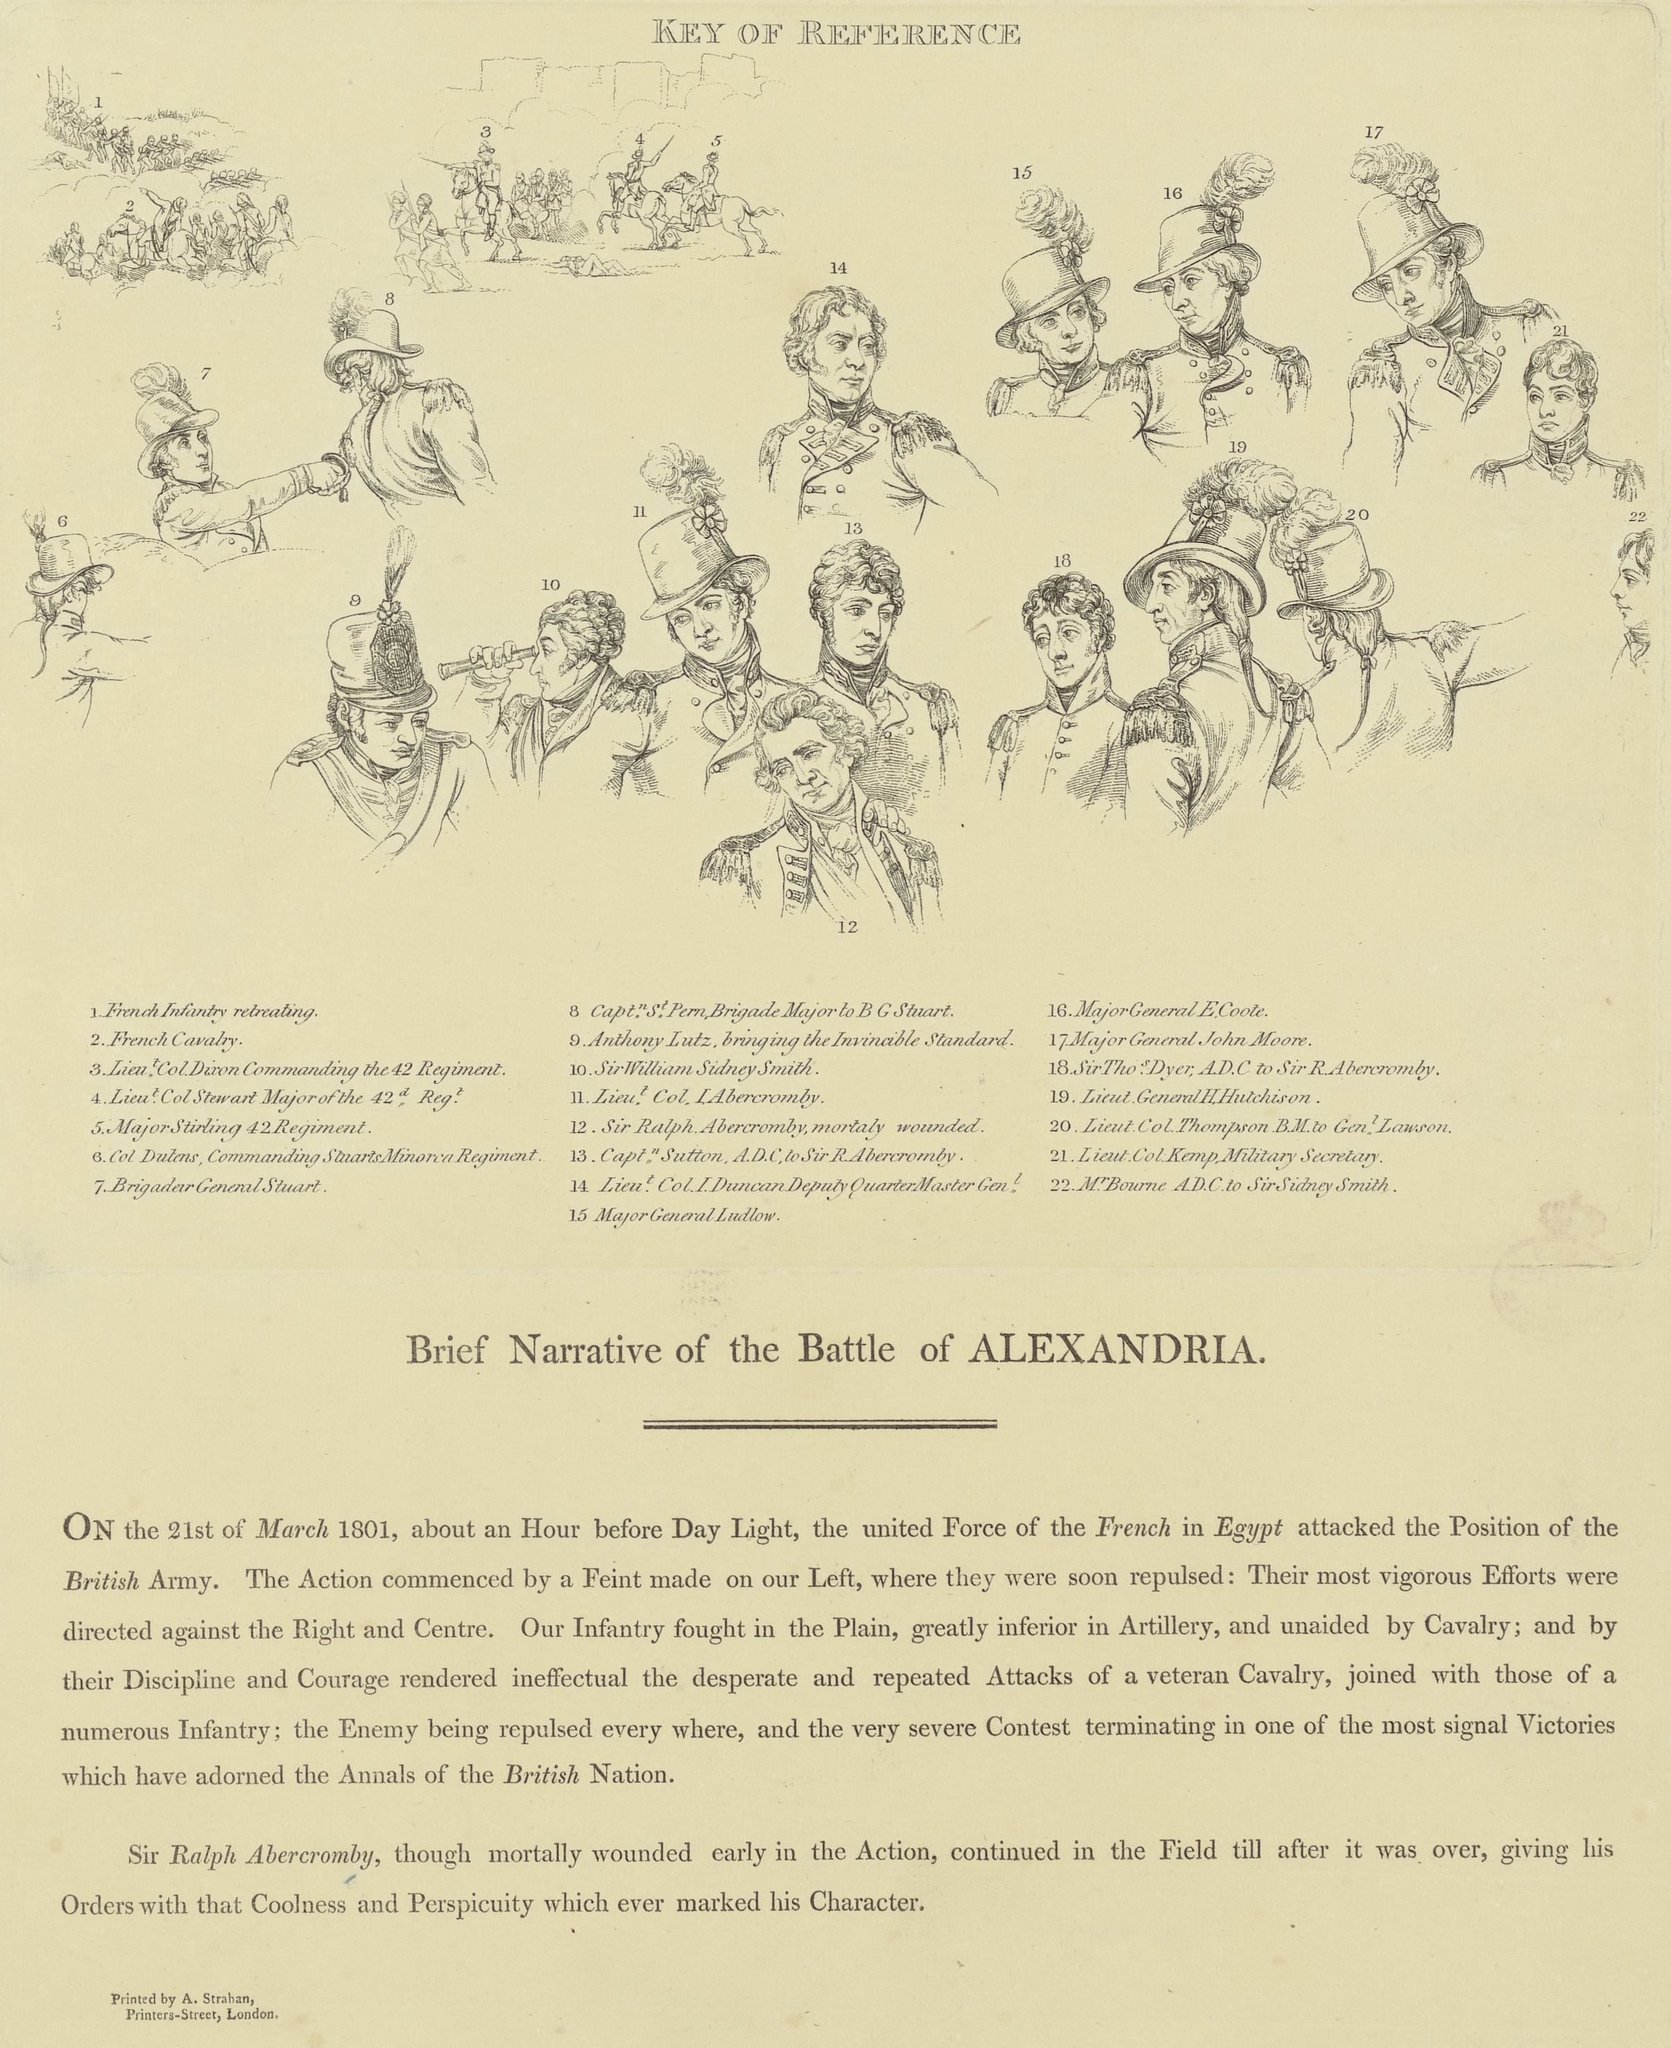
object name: print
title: Verklaring van de prent 'De slag om Alexandrië'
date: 1806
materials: paper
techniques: engraving, etching, letterpress printing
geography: london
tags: battle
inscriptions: collector's mark: Lugt 12